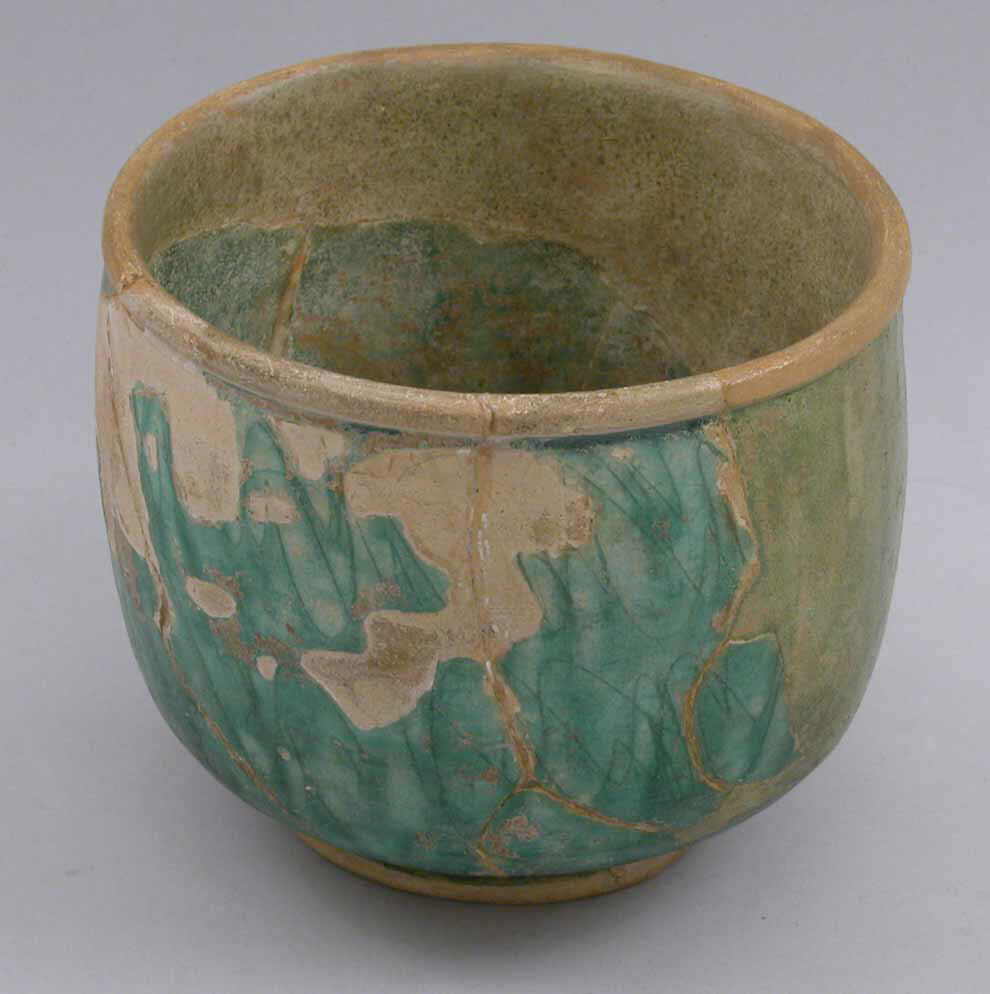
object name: jar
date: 901-1000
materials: earthenware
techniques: glazing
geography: iran